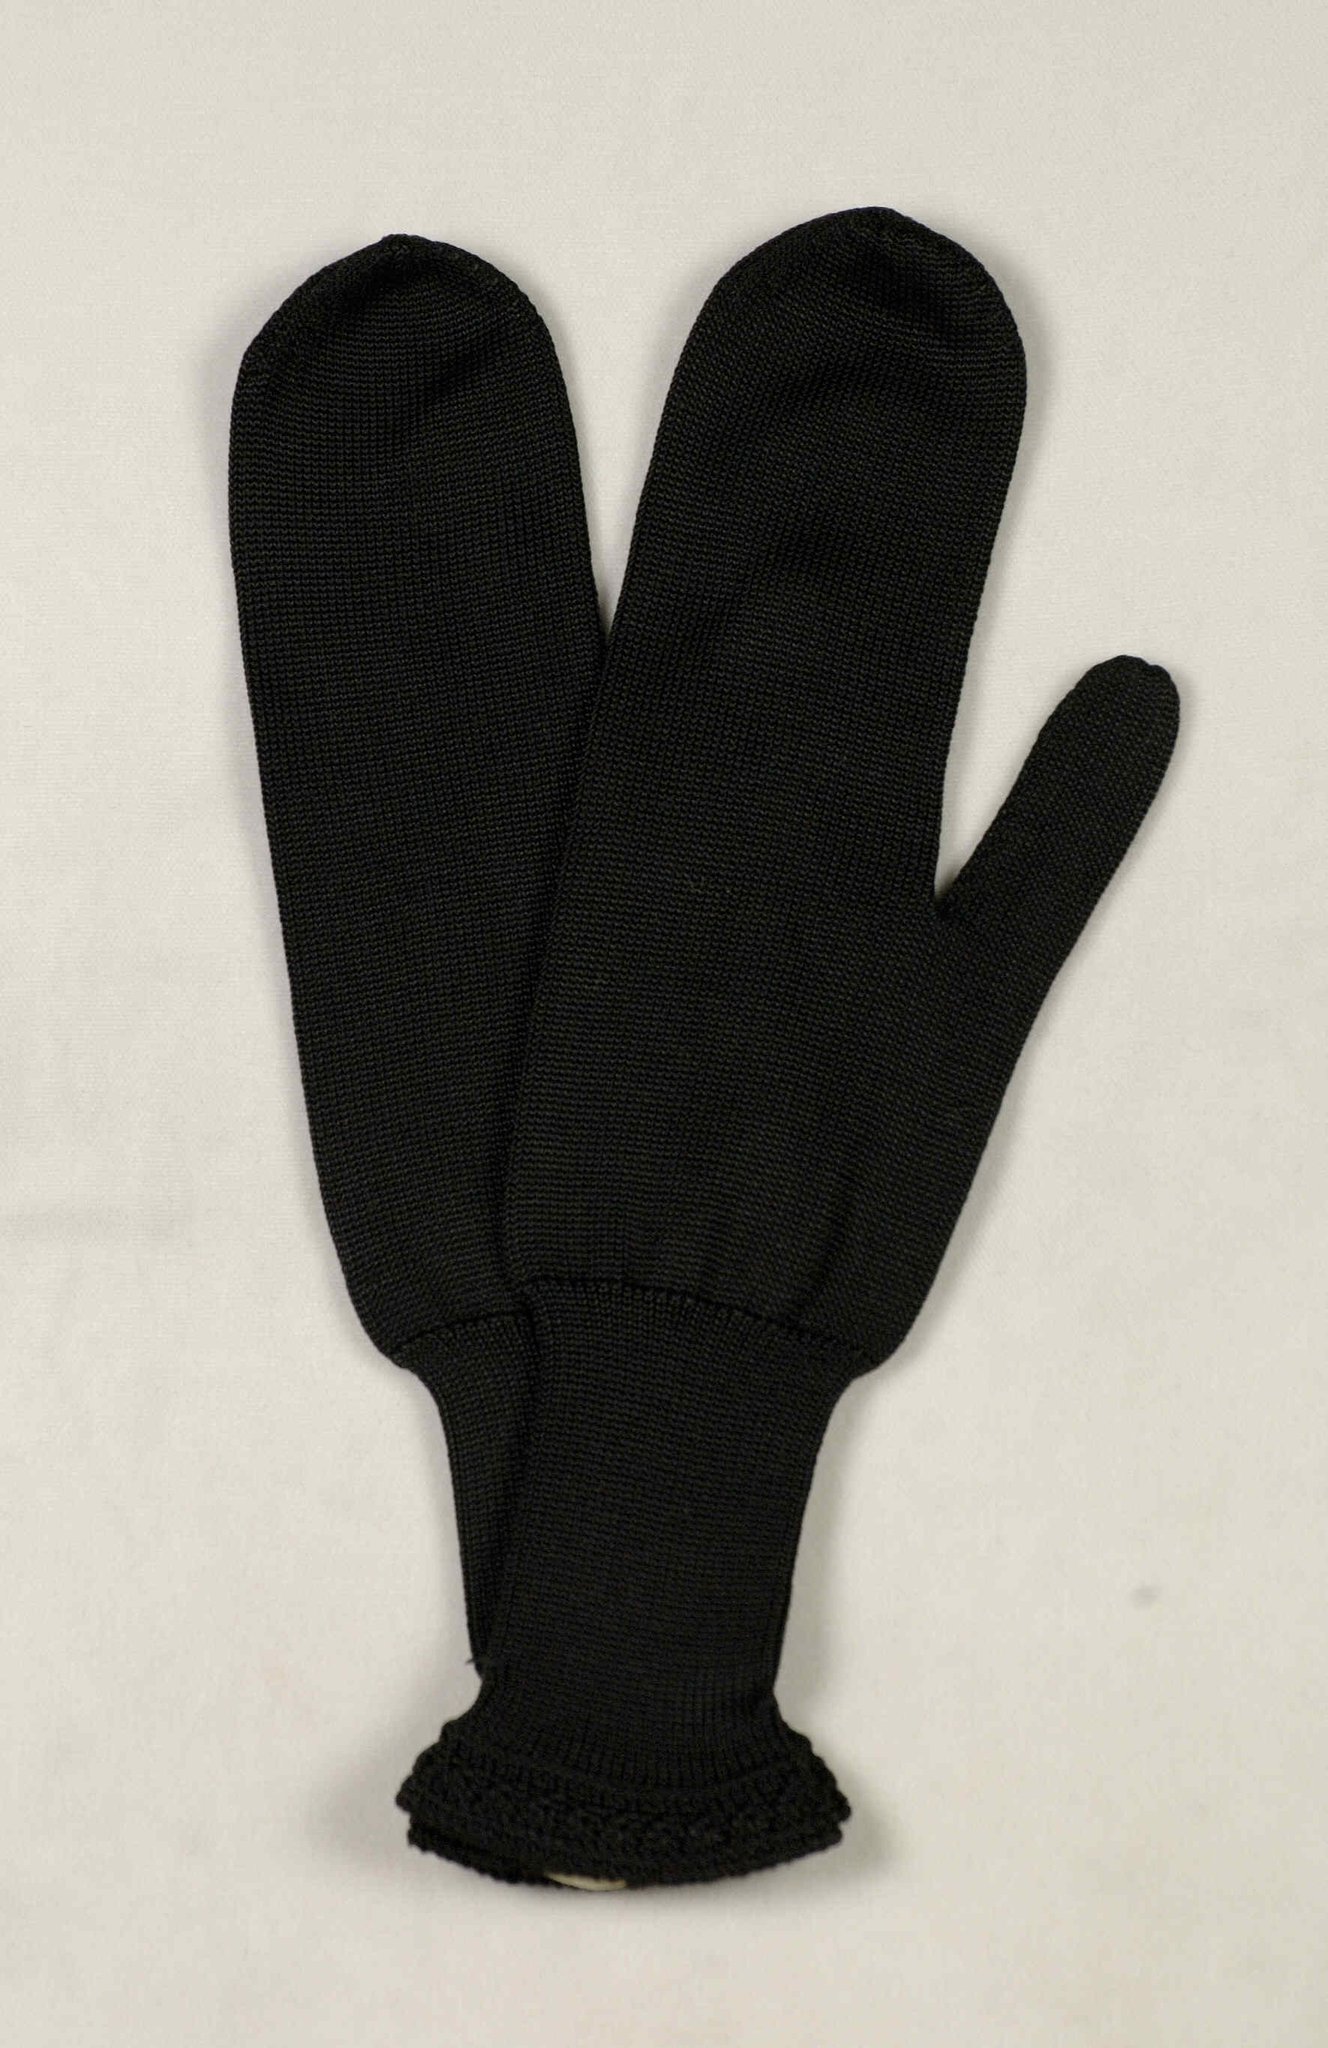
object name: mitten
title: Mittens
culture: american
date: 1870-1875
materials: silk